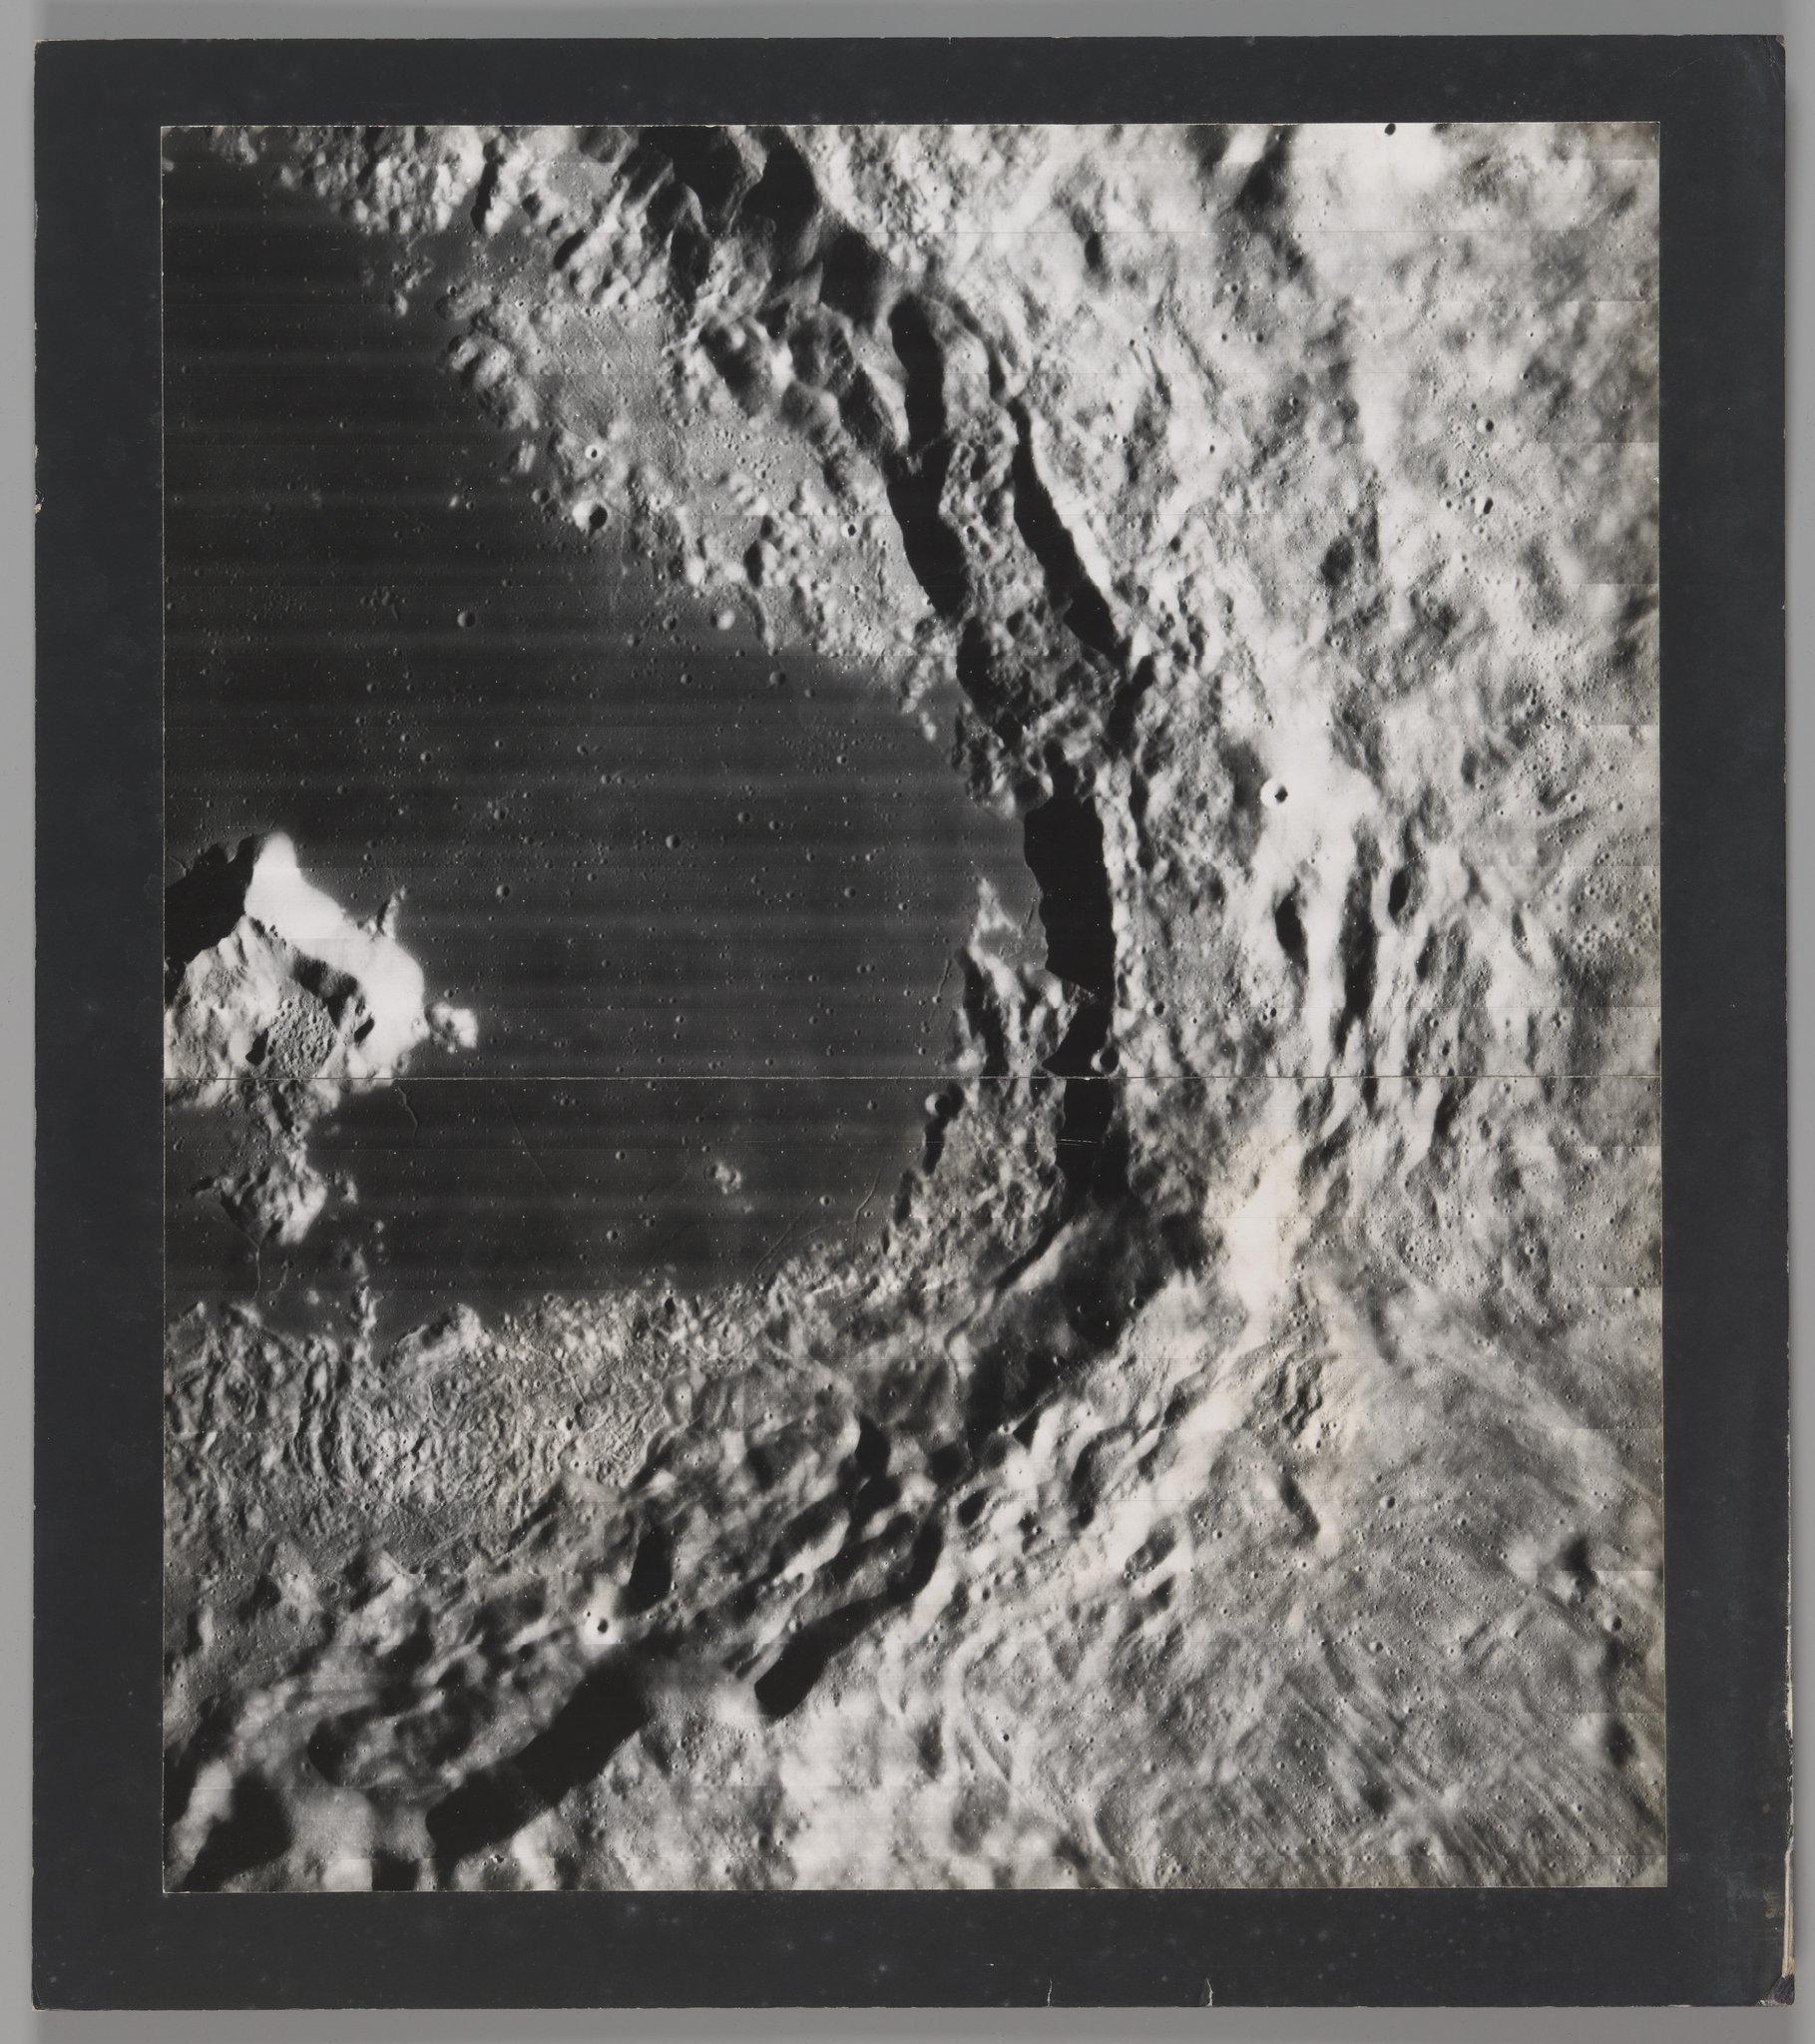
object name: photograph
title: Far Side of the Moon at Apolune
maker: national aeronautics and space administration (nasa)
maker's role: artist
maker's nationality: american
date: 1967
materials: photographic print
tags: moon,astronomy